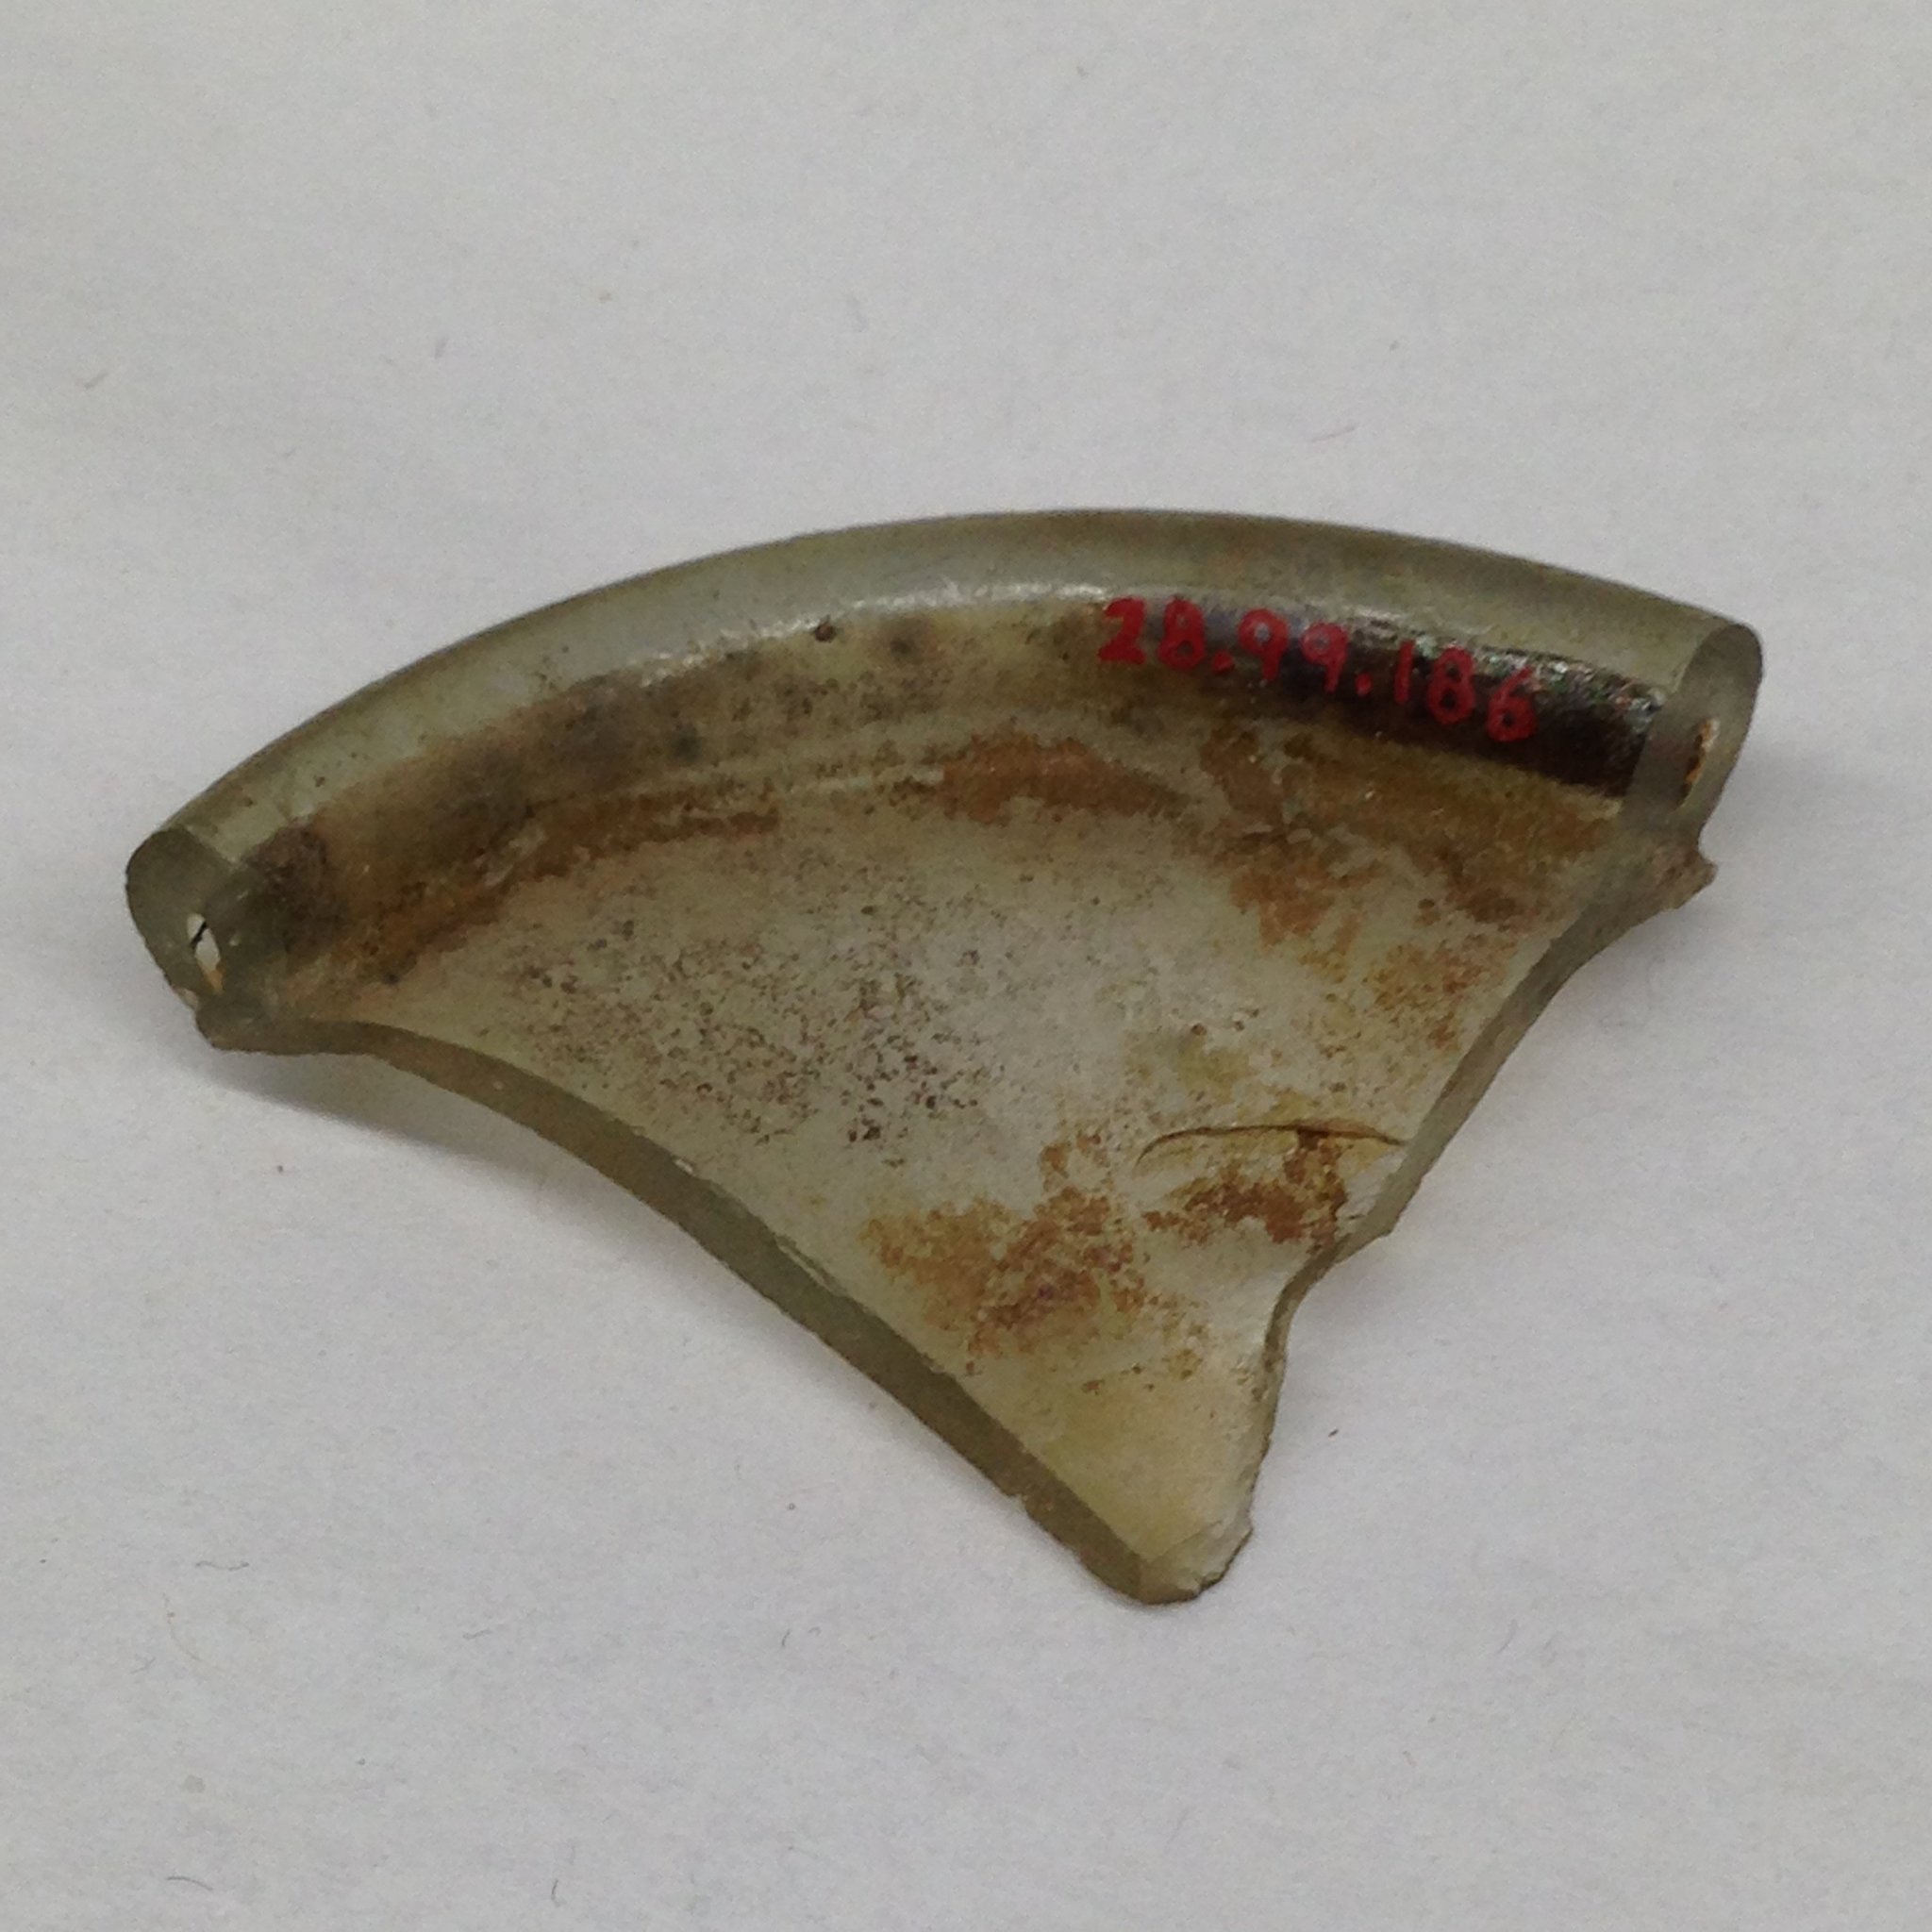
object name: fragment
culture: european or middle eastern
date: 1150-1250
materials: ceramic, glass